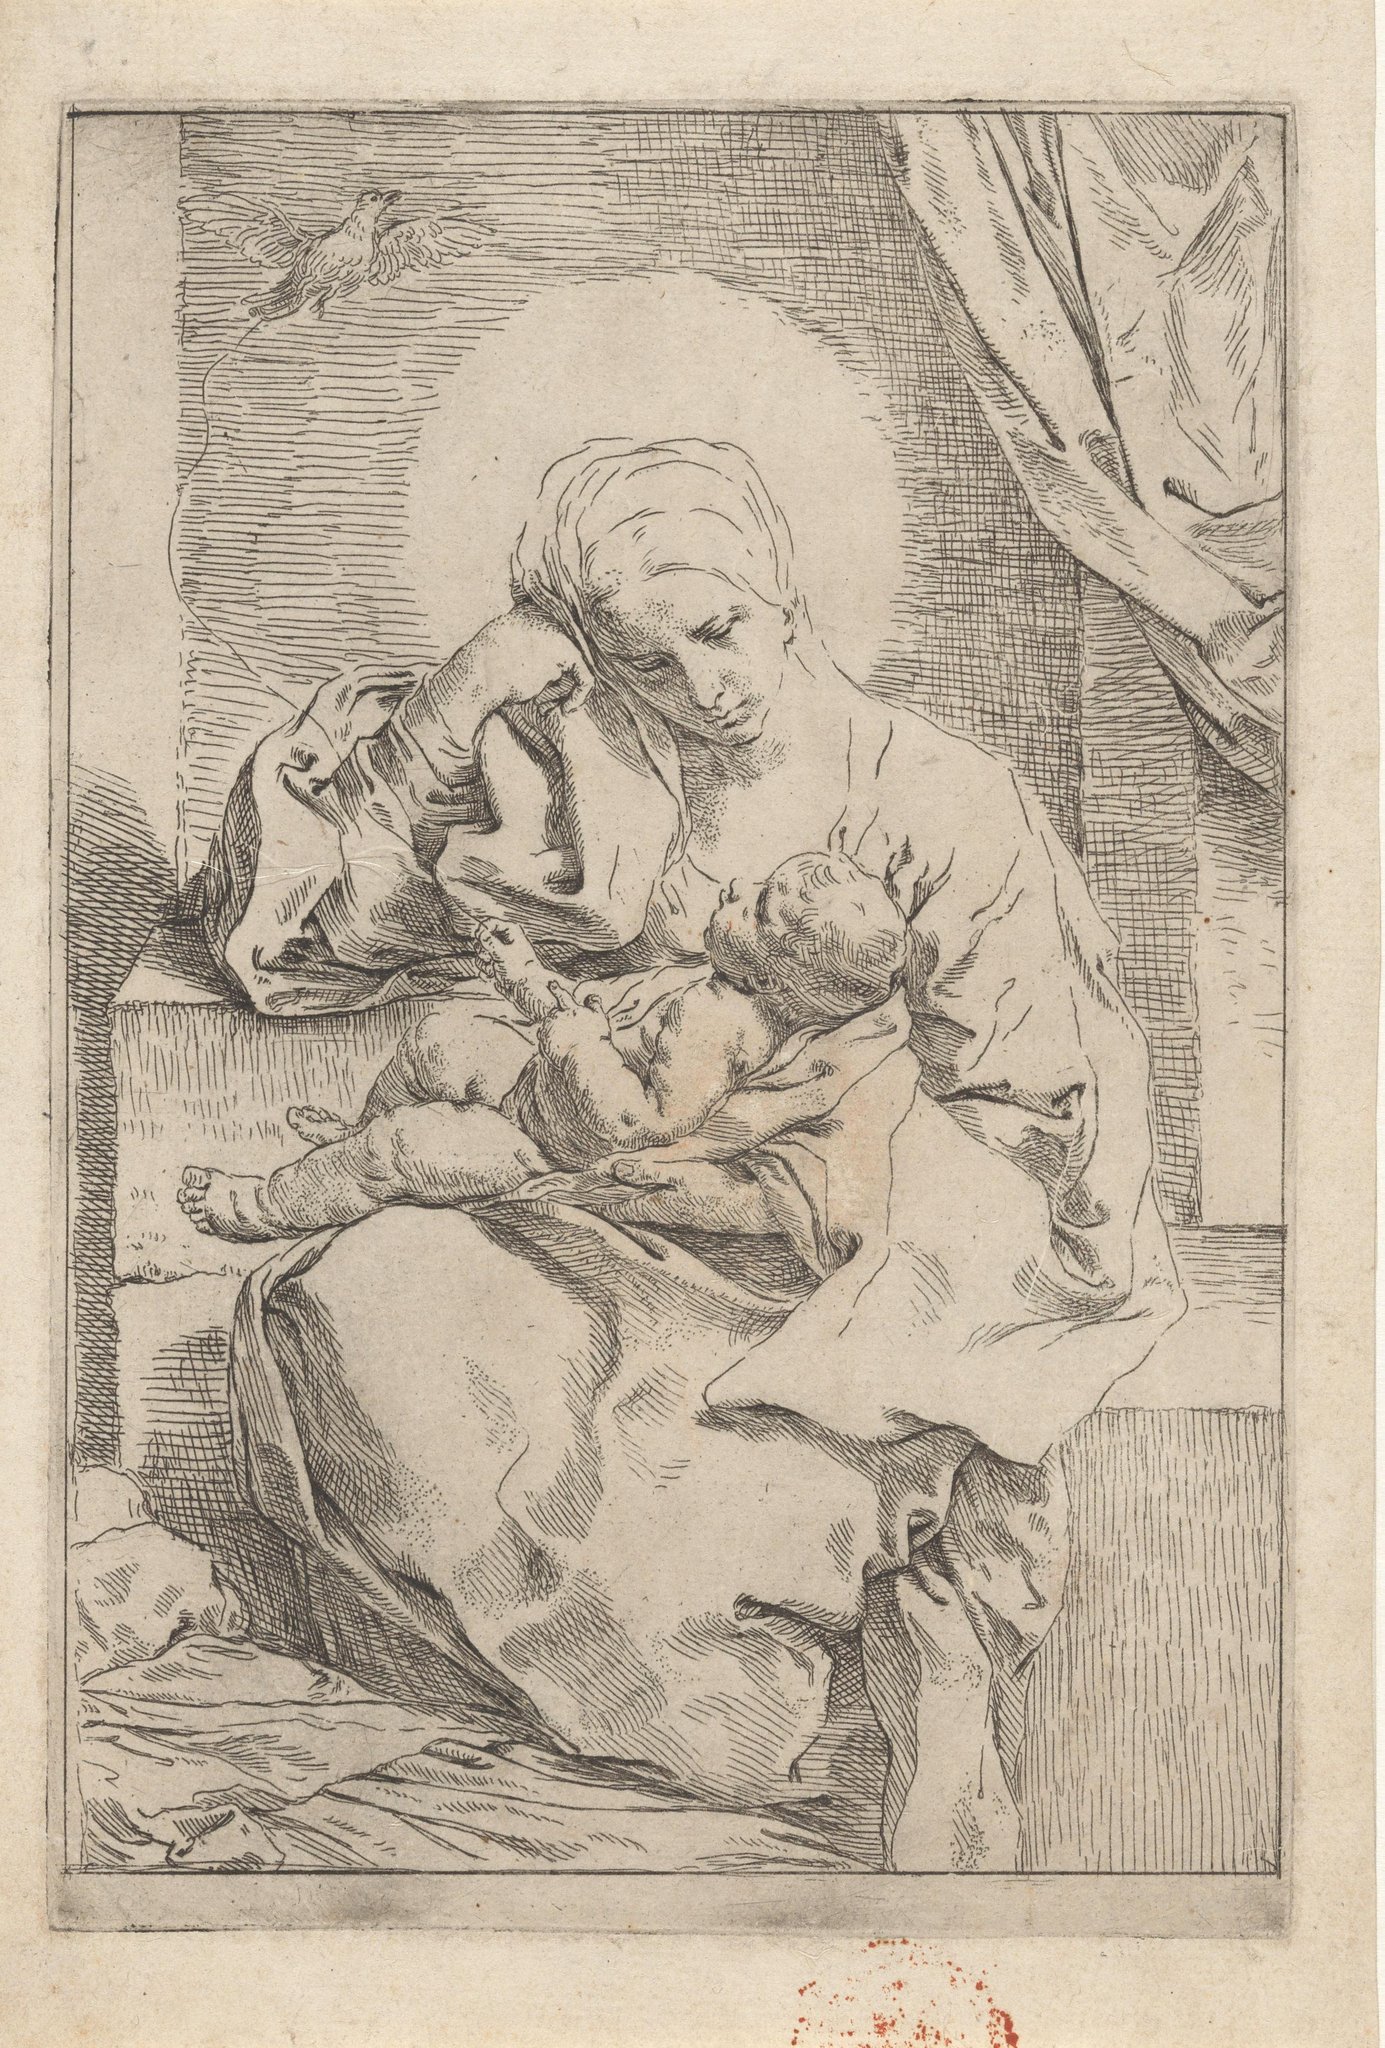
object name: print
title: Maria met Kind en vogel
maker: simone cantarini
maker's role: draughtsman, print maker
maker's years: 1612-1648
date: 1622-1648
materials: paper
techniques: etching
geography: italy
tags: madonna: i.e. mary with the christ-child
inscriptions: collector's mark: Lugt 240, collector's mark: Lugt 2228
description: Maria zit met het Christuskind op schoot. Christus heeft in zijn hand een touw waar een vogel aan vast zit.